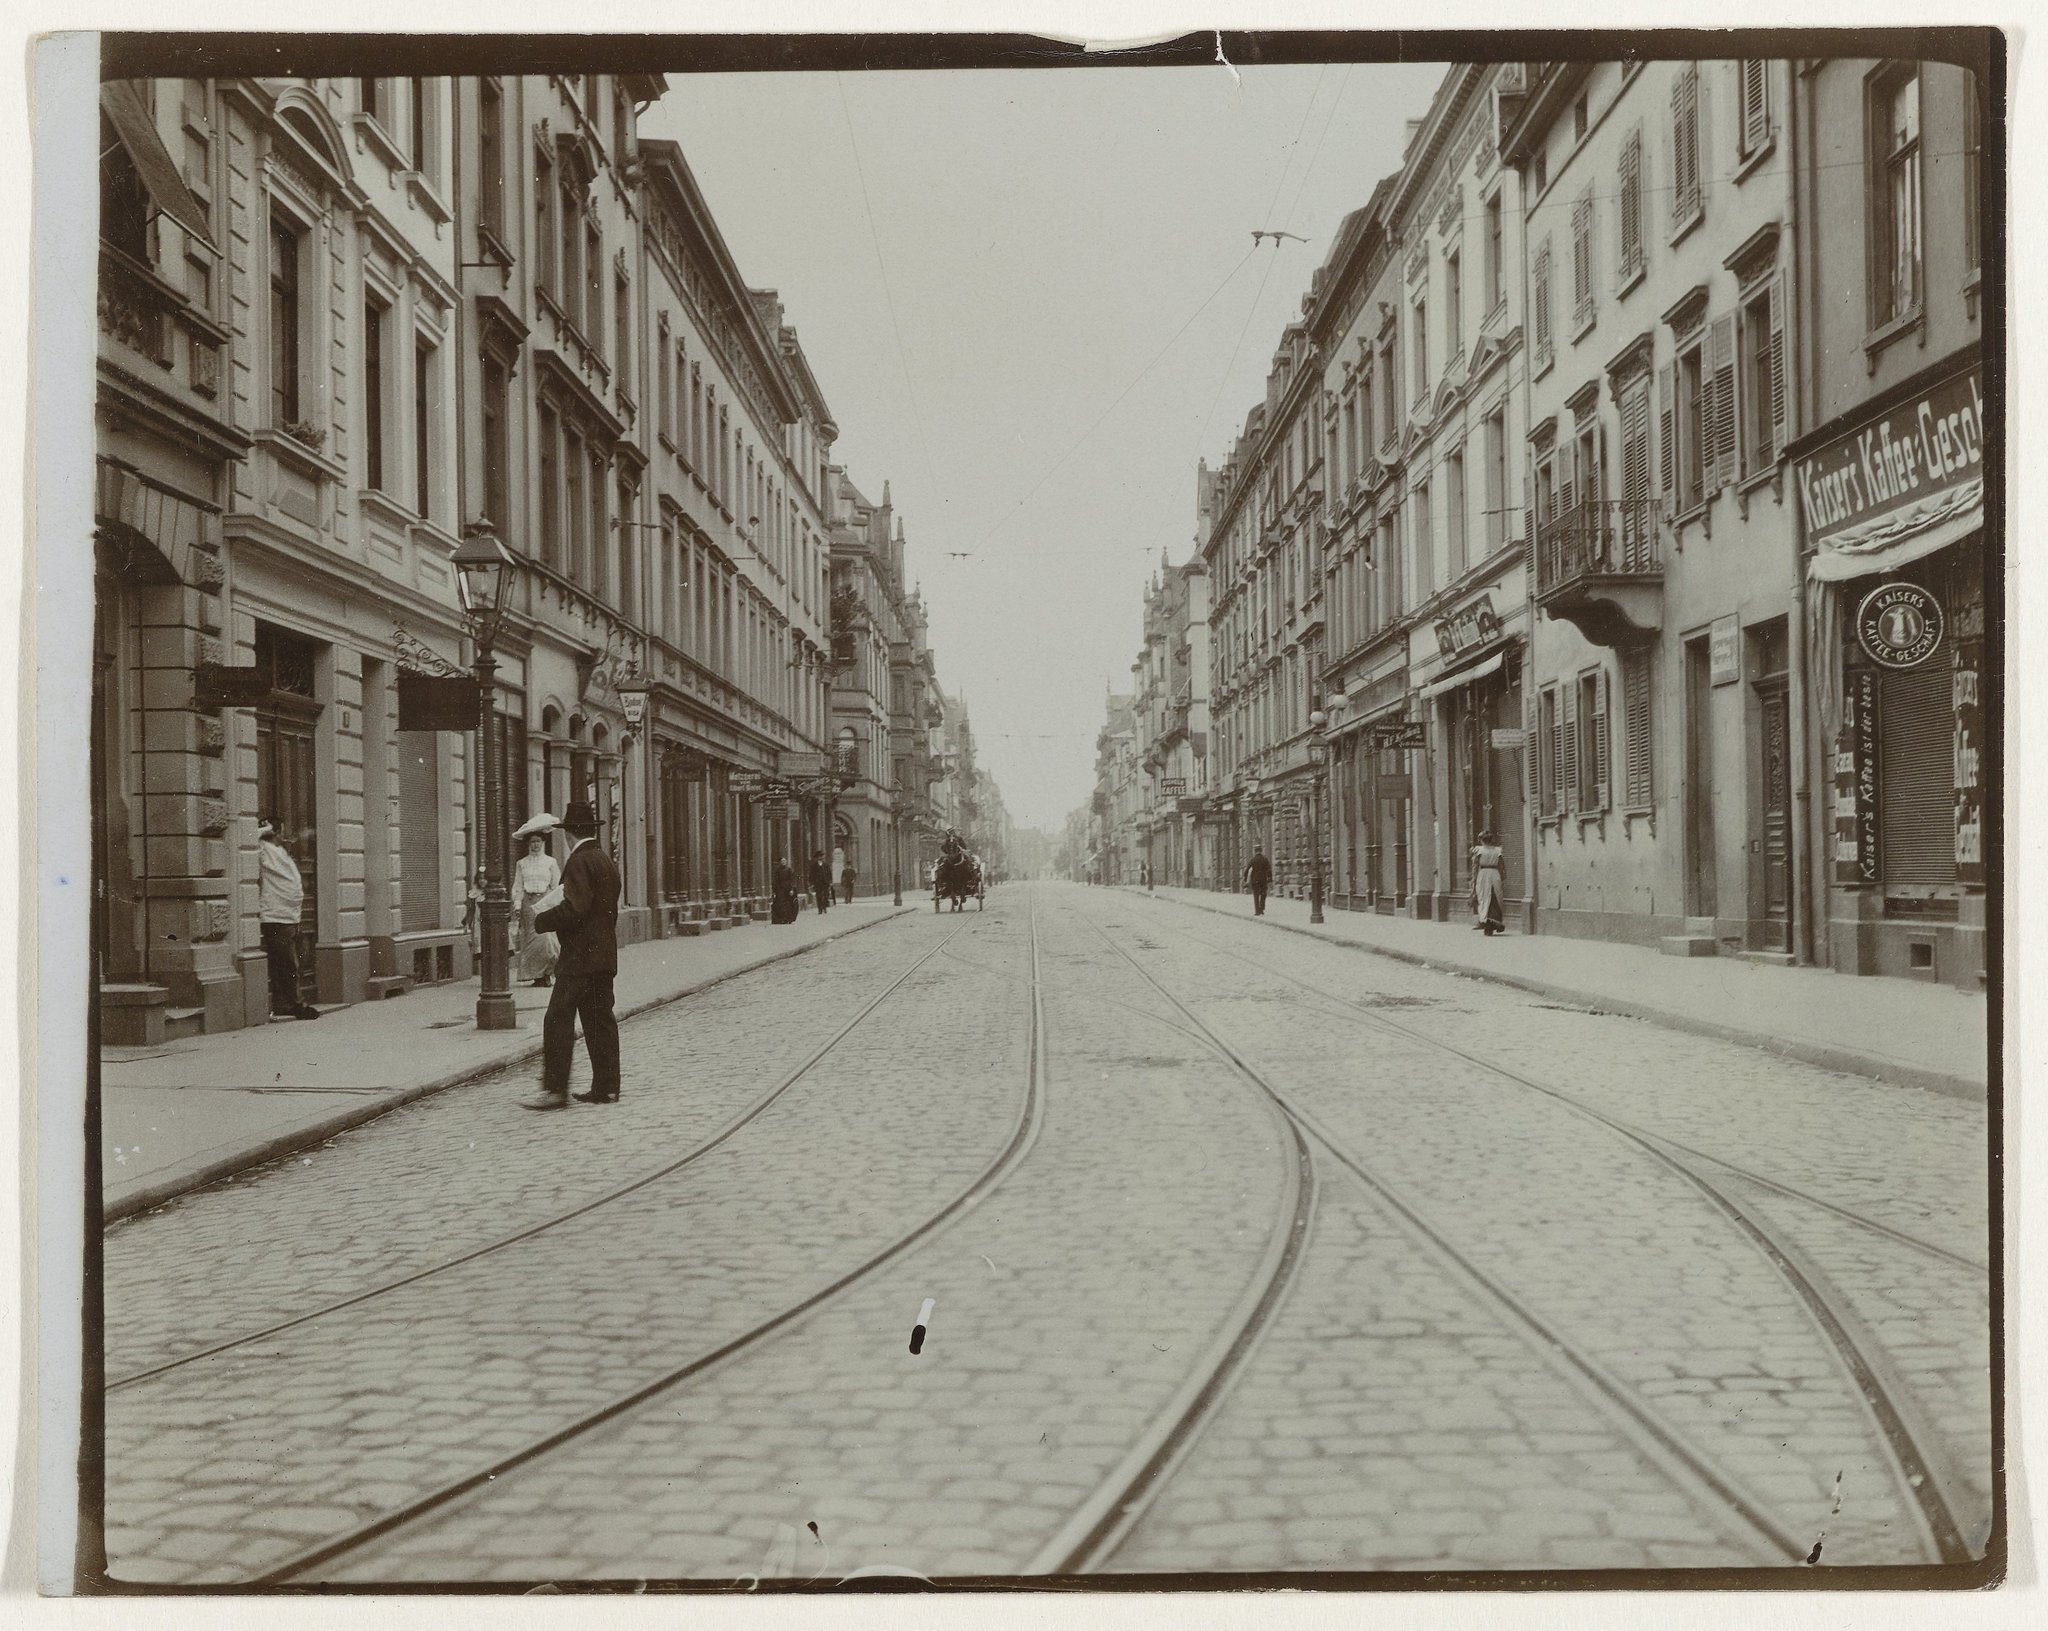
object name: photograph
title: Gezicht in een stad, mogelijk in Duitsland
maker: Anonymous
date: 1900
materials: paper, photographic support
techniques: collodion silver print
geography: germany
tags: tramway, tram, street, germany